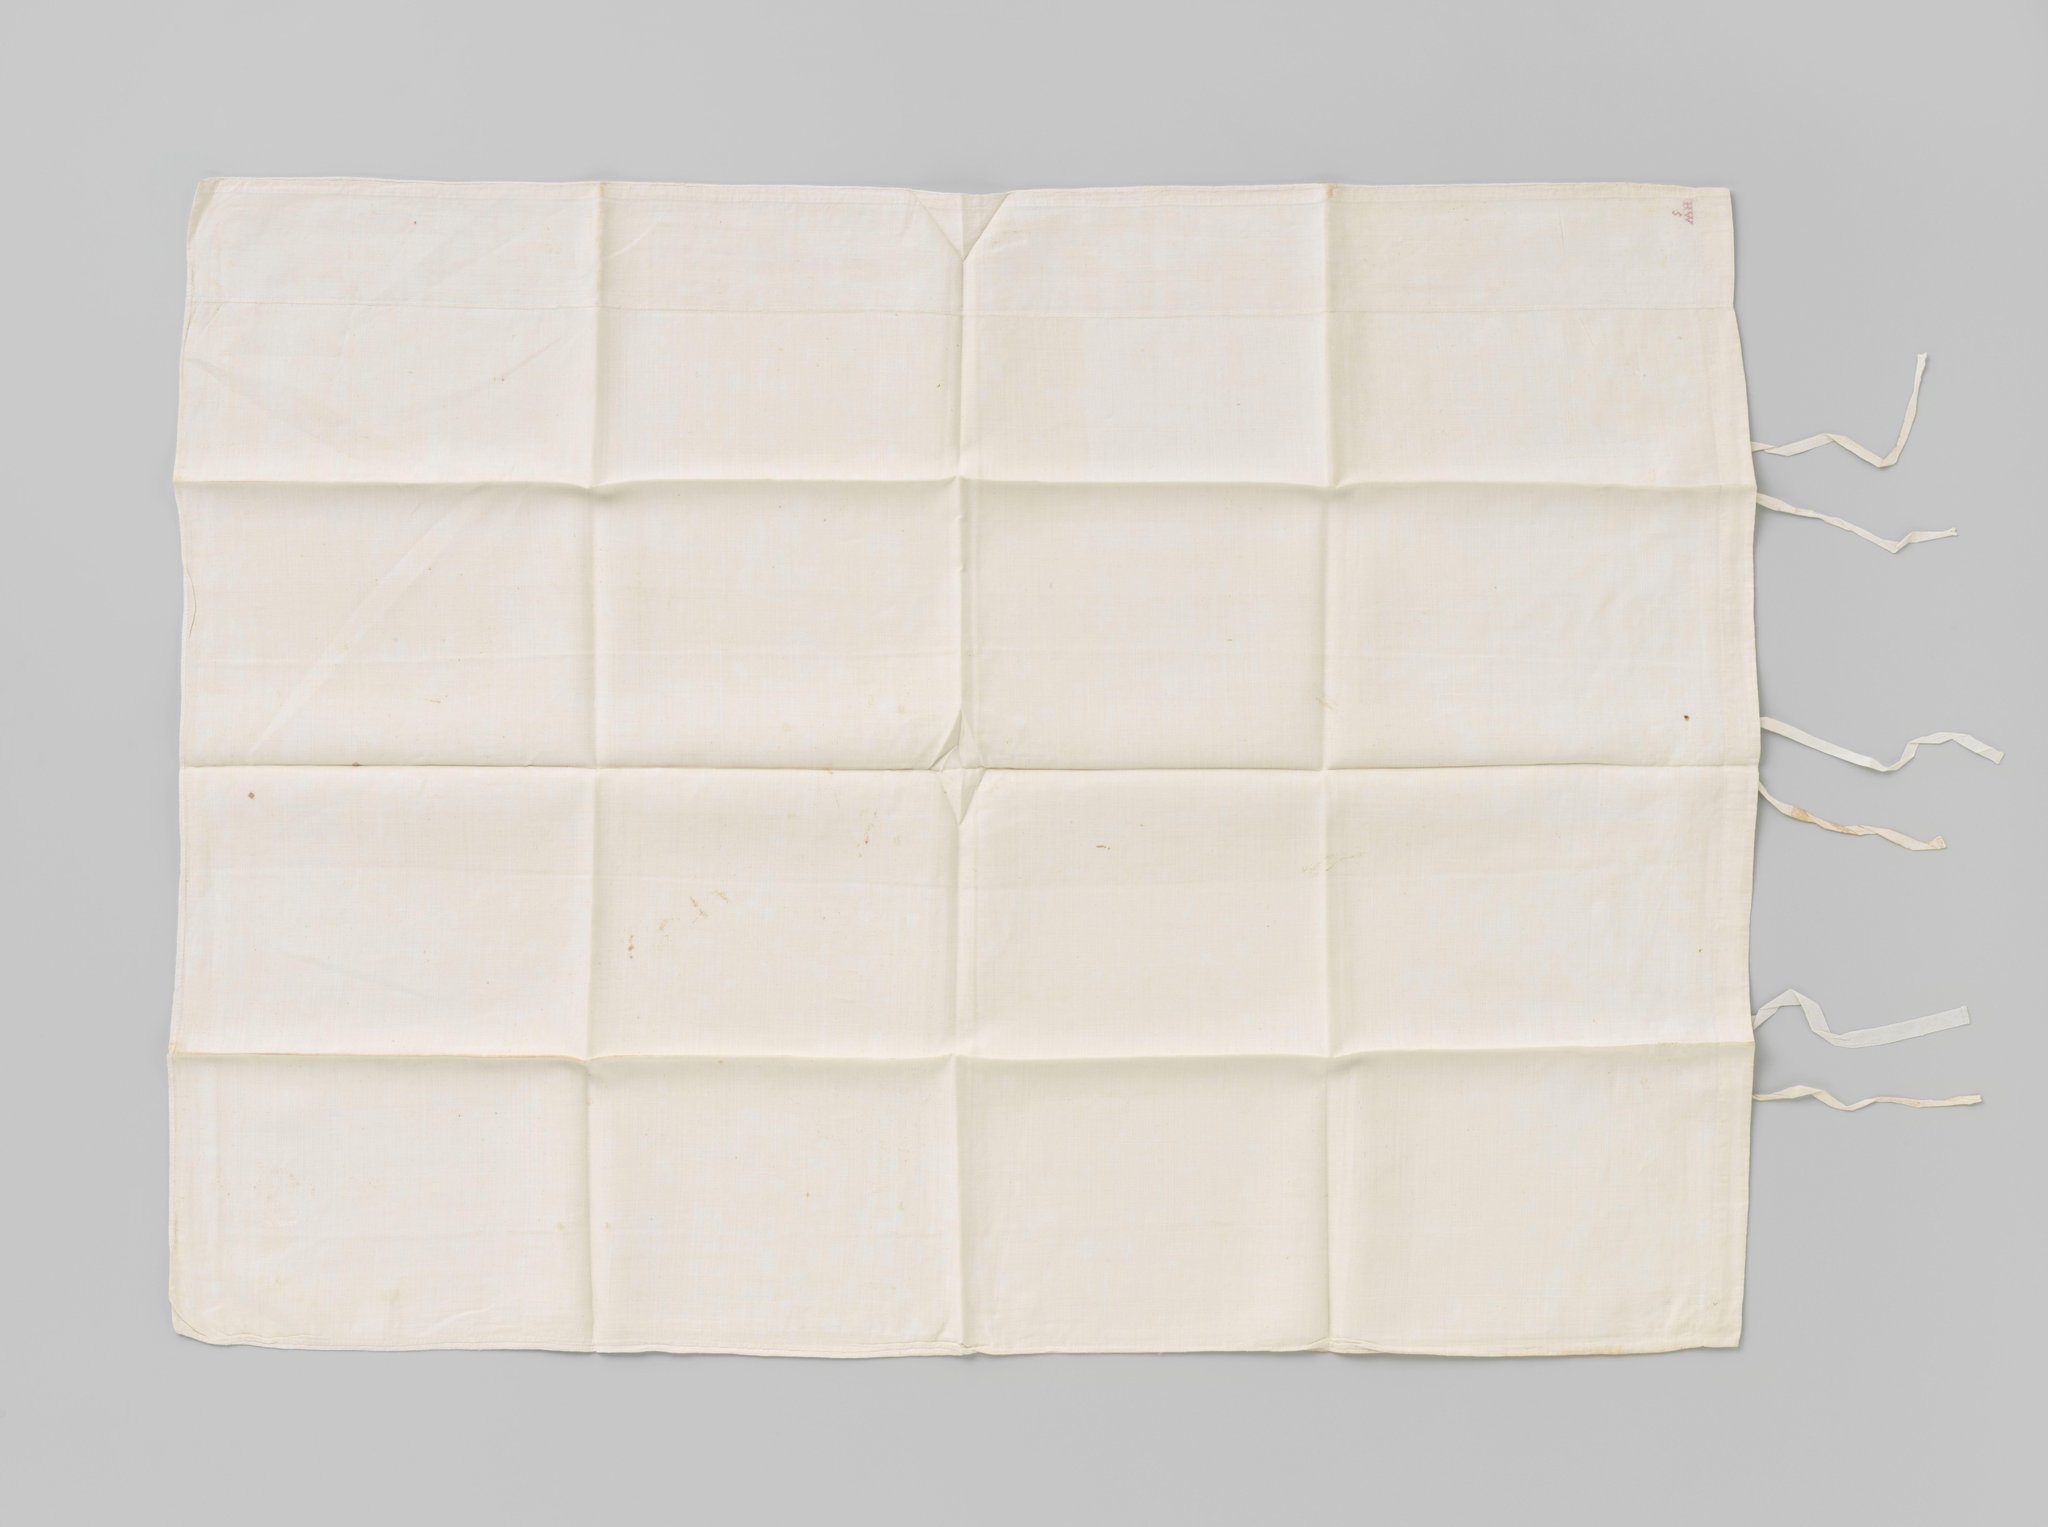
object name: sloop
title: Sloop van linnen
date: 1692-1735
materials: linen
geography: northern netherlands